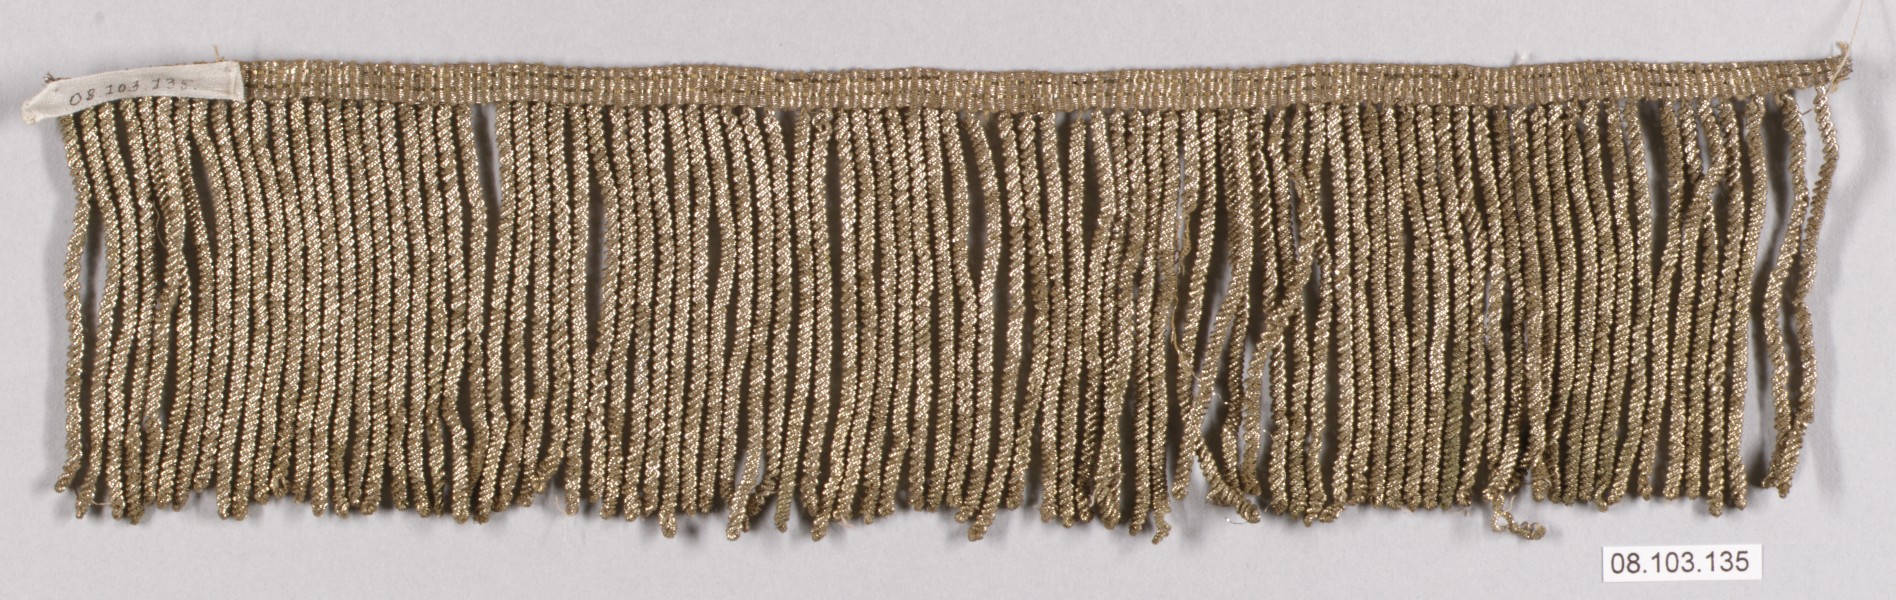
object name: fringe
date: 1801-1900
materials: metal thread